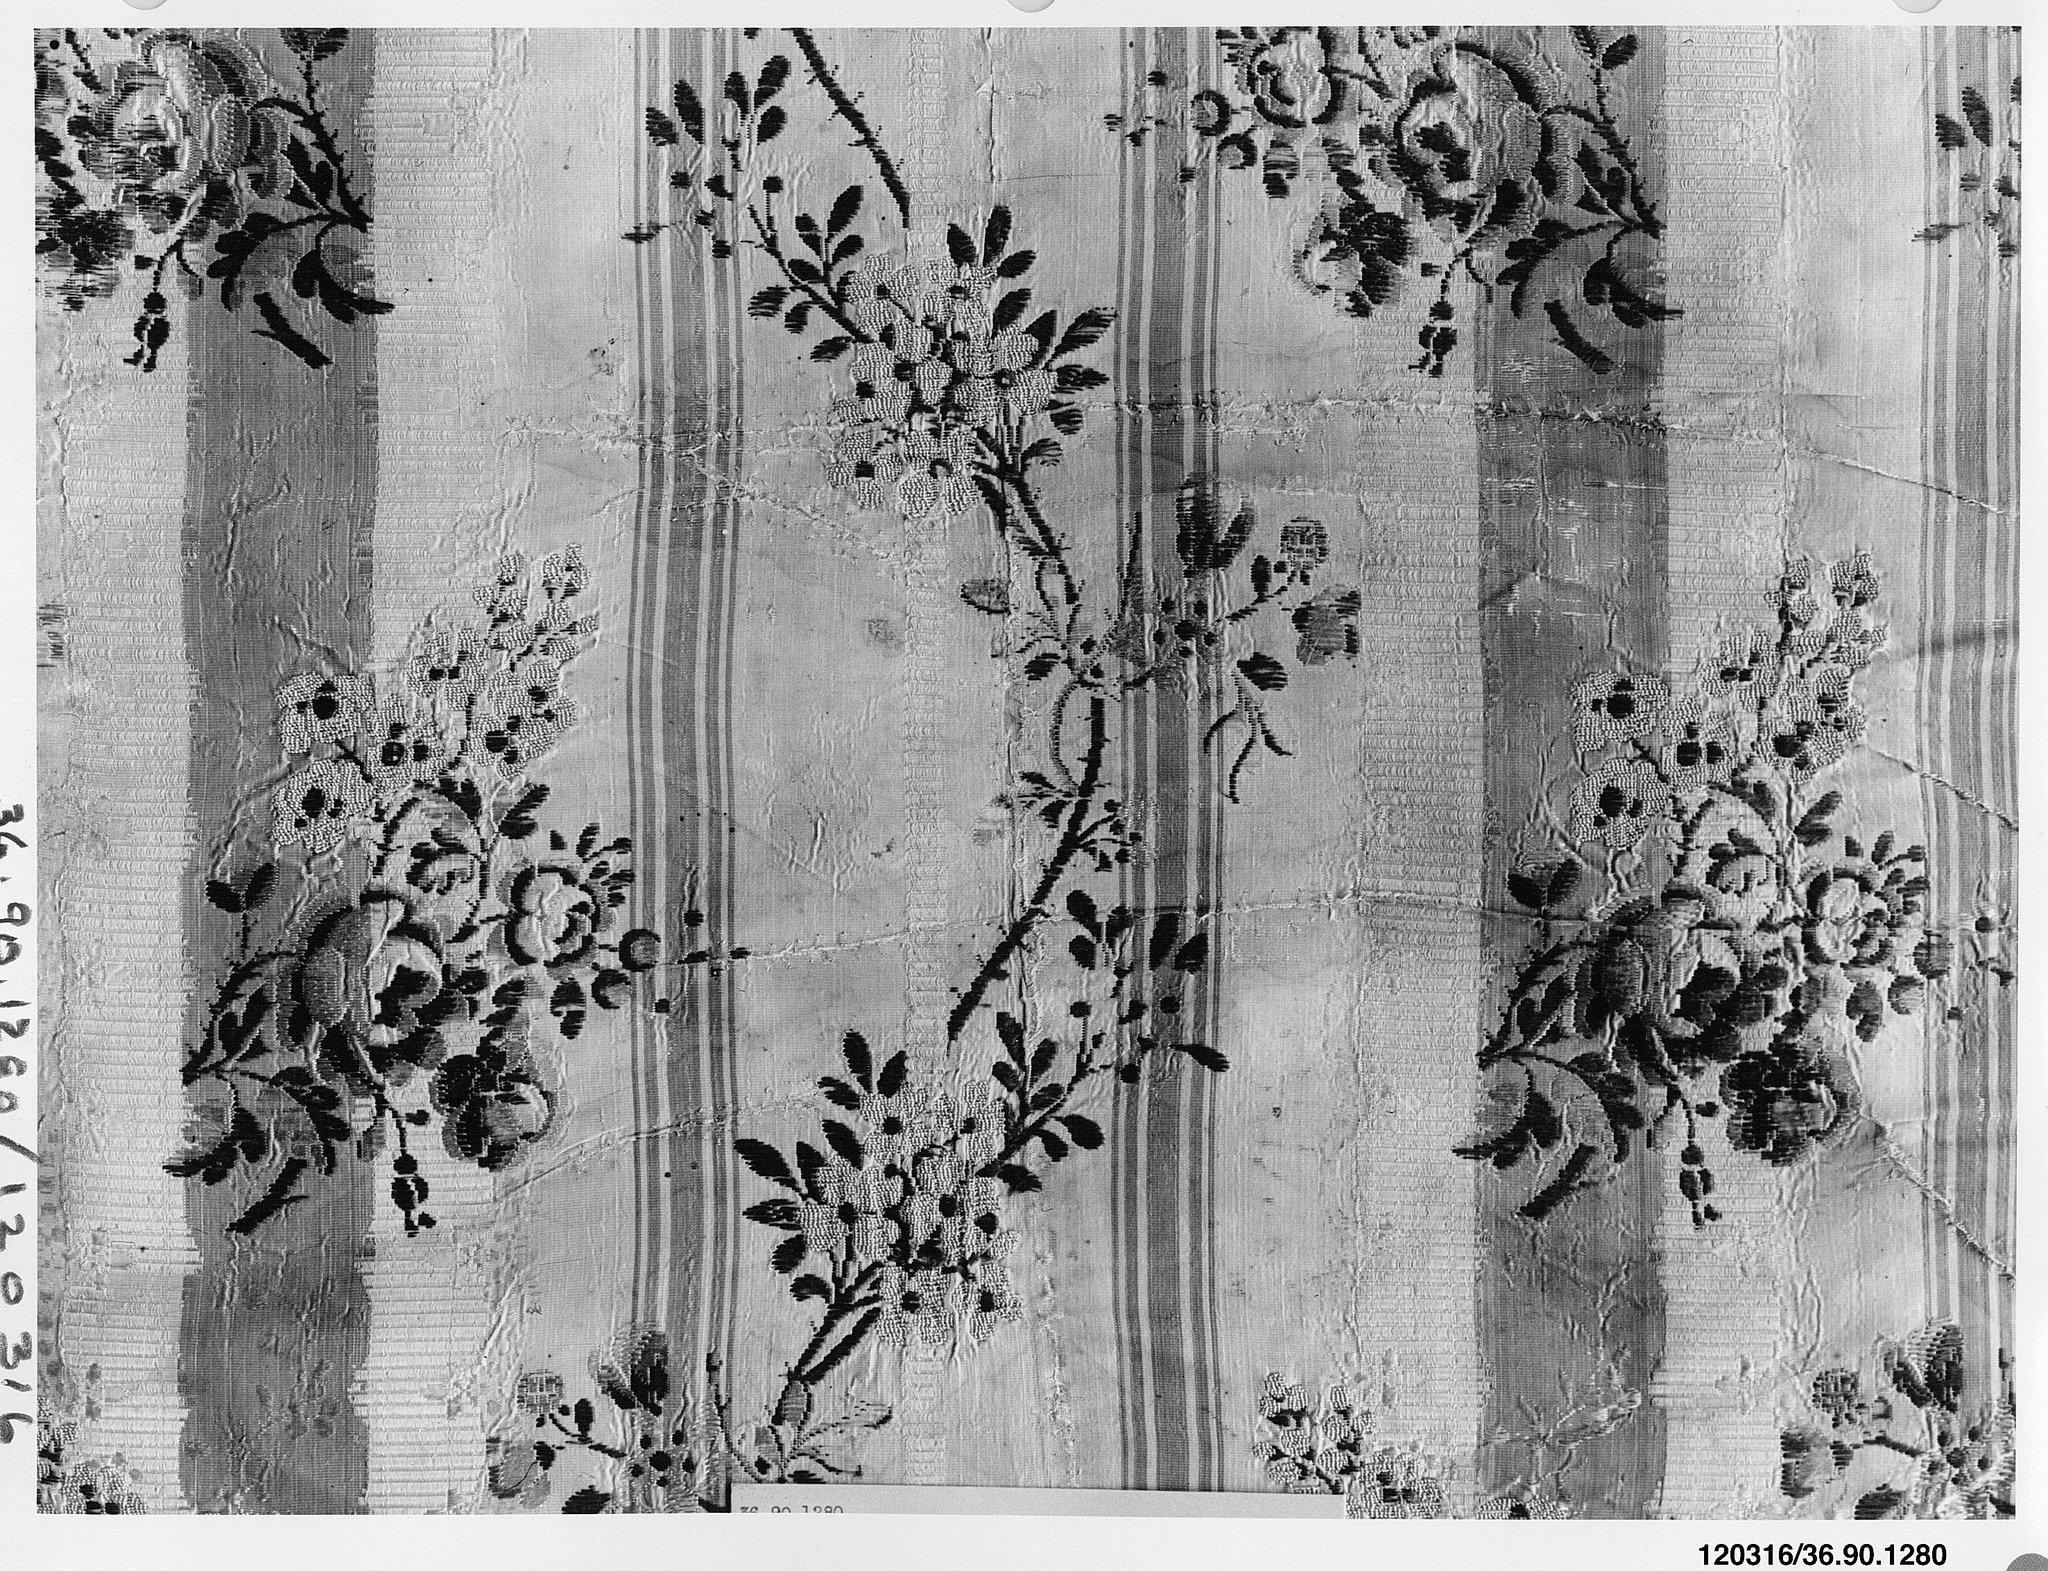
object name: piece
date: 1701-1800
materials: silk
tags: flowers,leaves